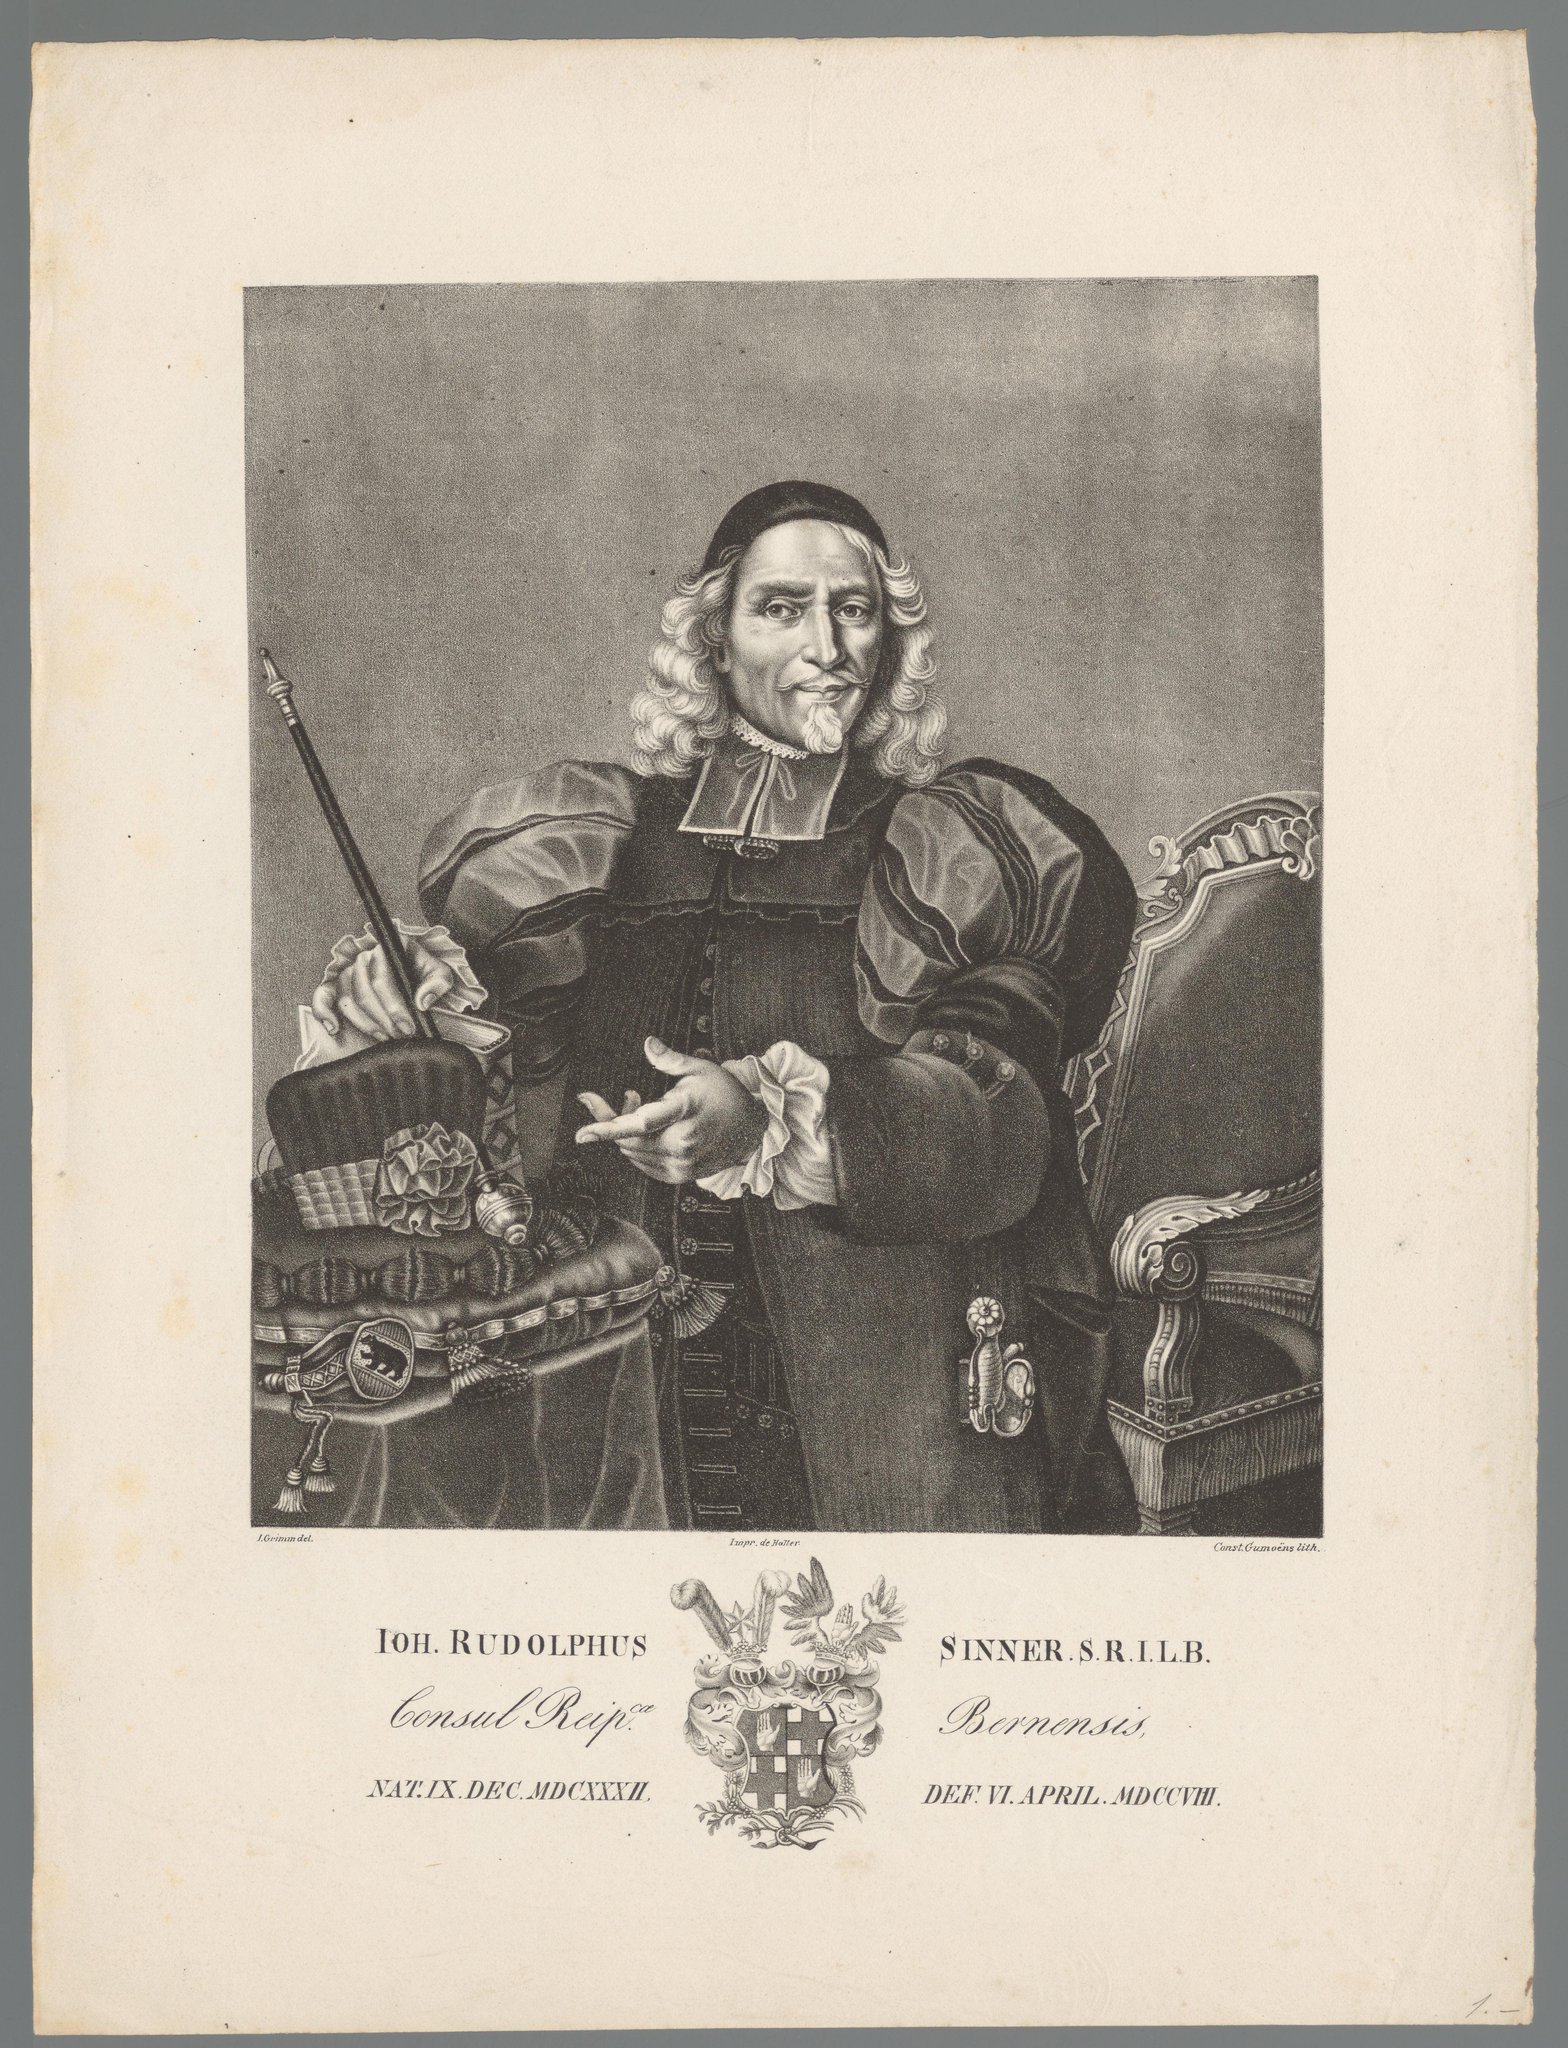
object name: print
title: Joh. Rudolphus Sinner S.R.I.L.B., Consul Reipcae. Bernensis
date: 1813-1864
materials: paper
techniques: lithograph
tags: politician, adult man, historical persons, beard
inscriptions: collector's mark: Lugt 2228